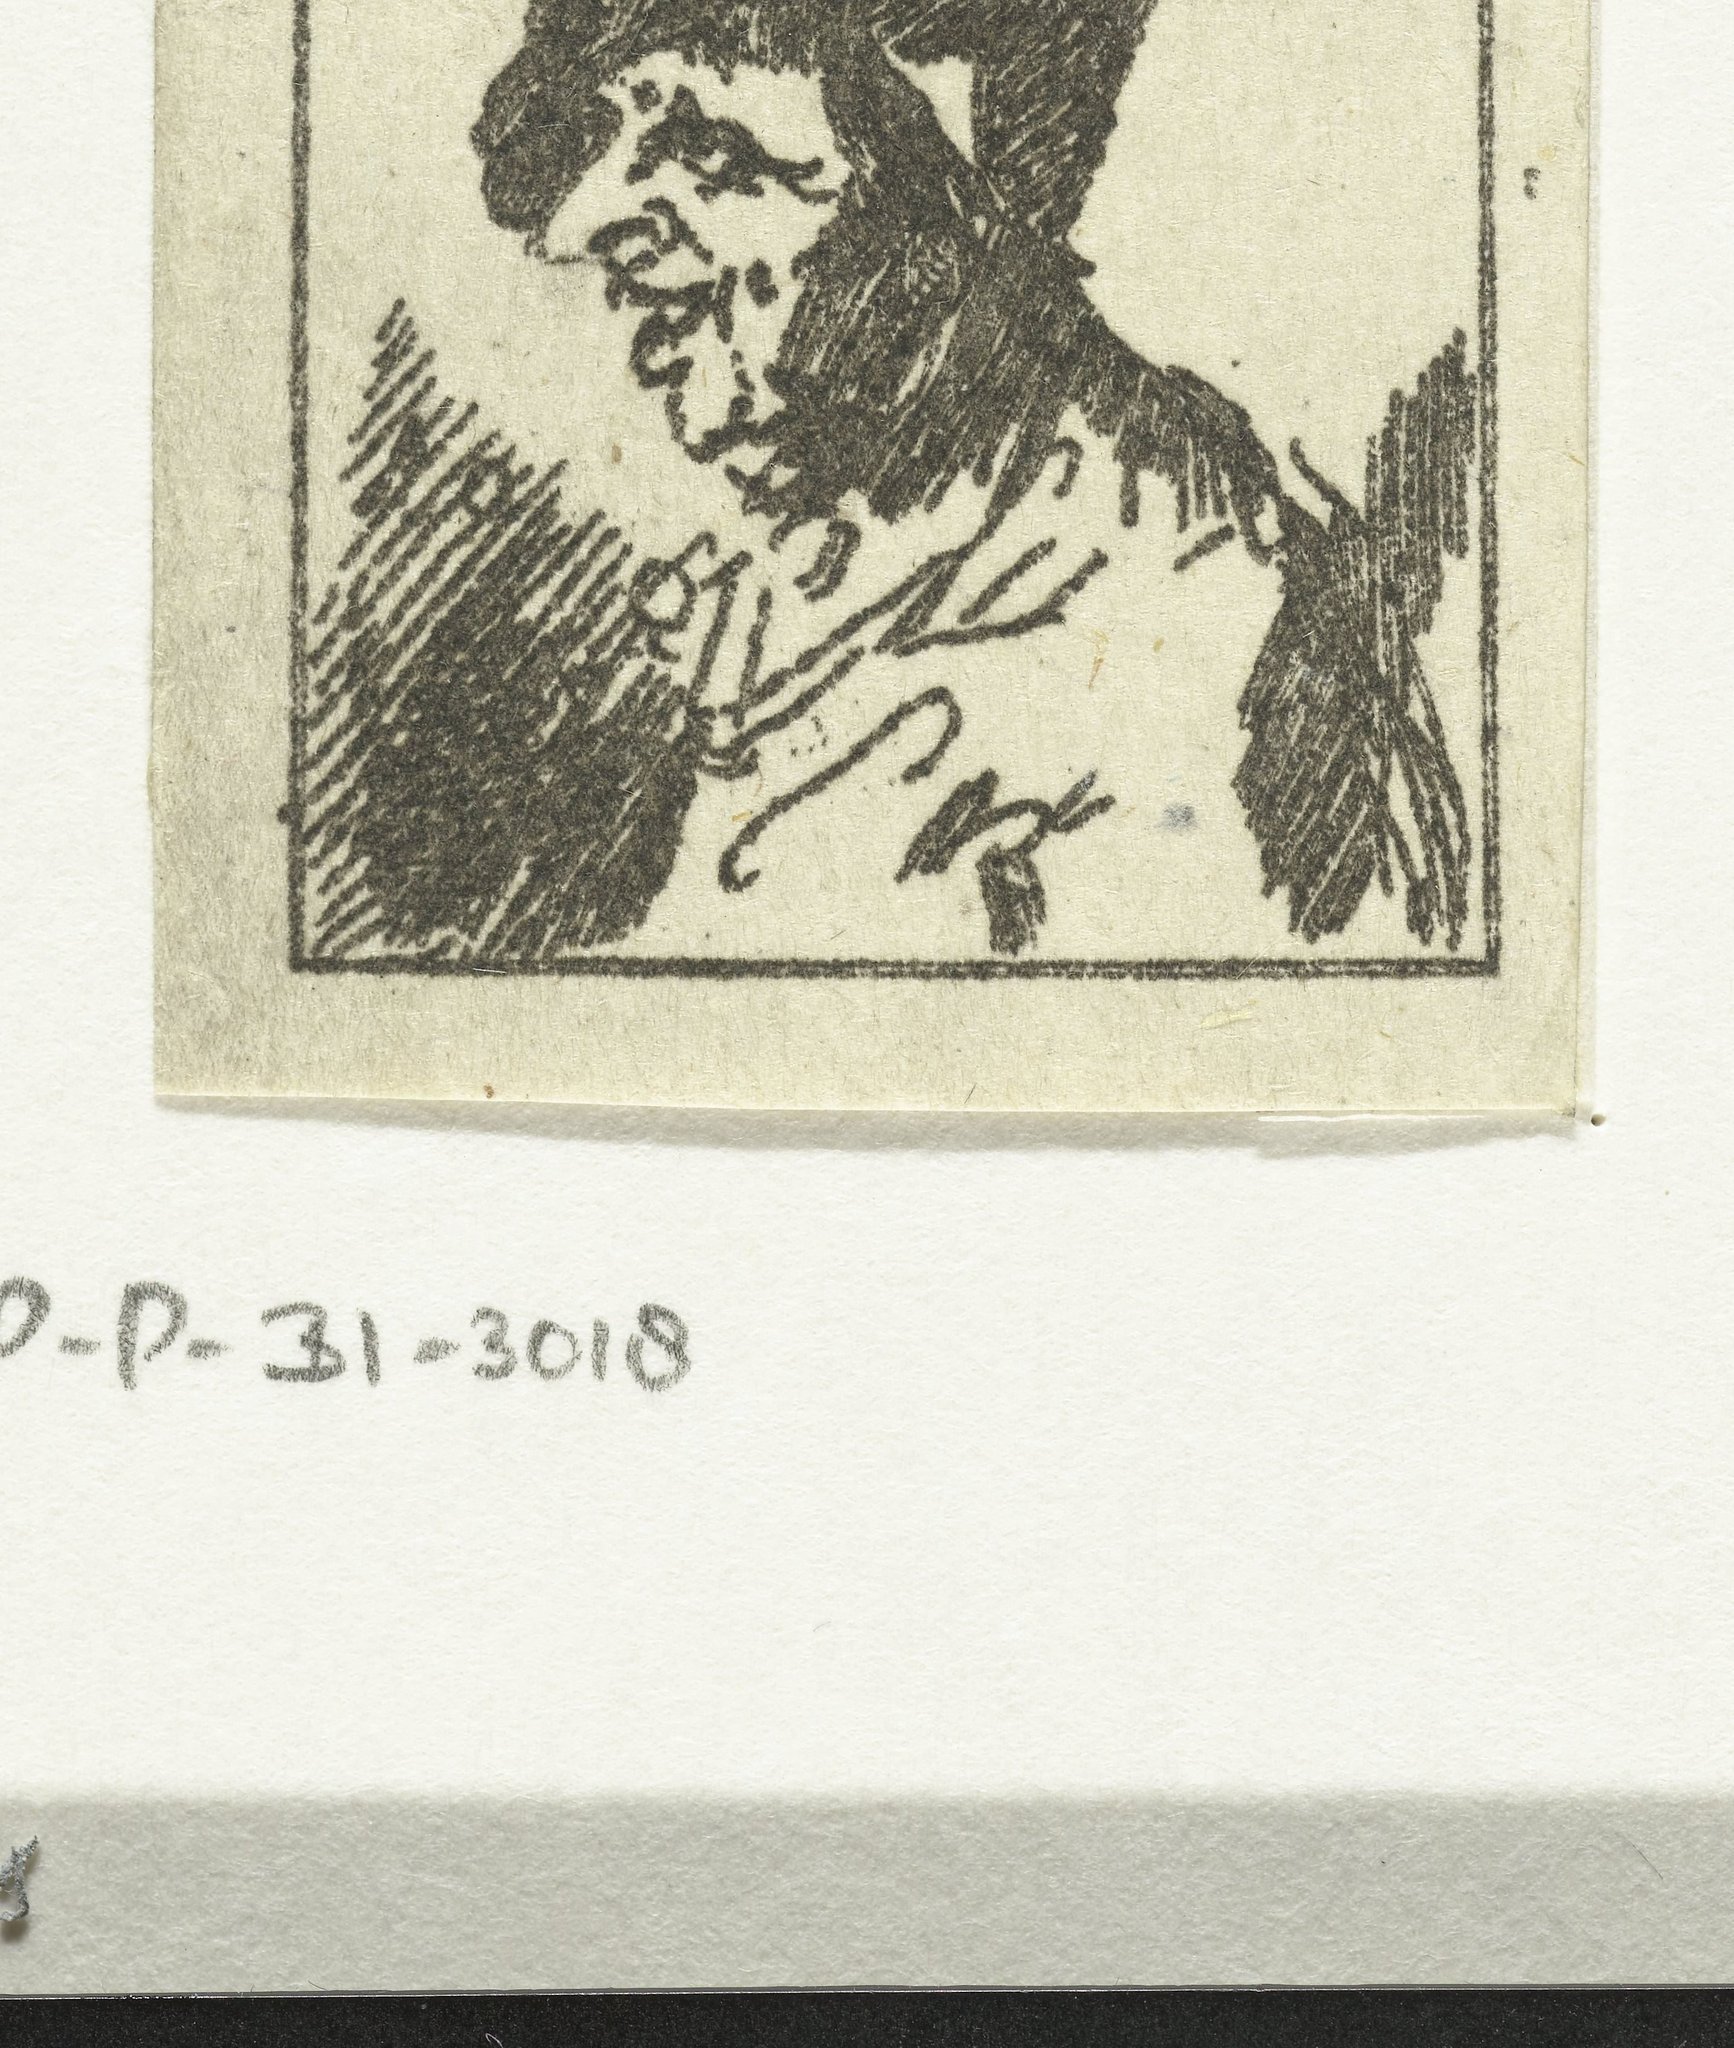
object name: print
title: Buste van een lachende boer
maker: anthonie van den bos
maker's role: draughtsman, print maker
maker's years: 1763-1838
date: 1778-1838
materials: paper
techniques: etching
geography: netherlands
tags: laughing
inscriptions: collector's mark: Lugt 2228